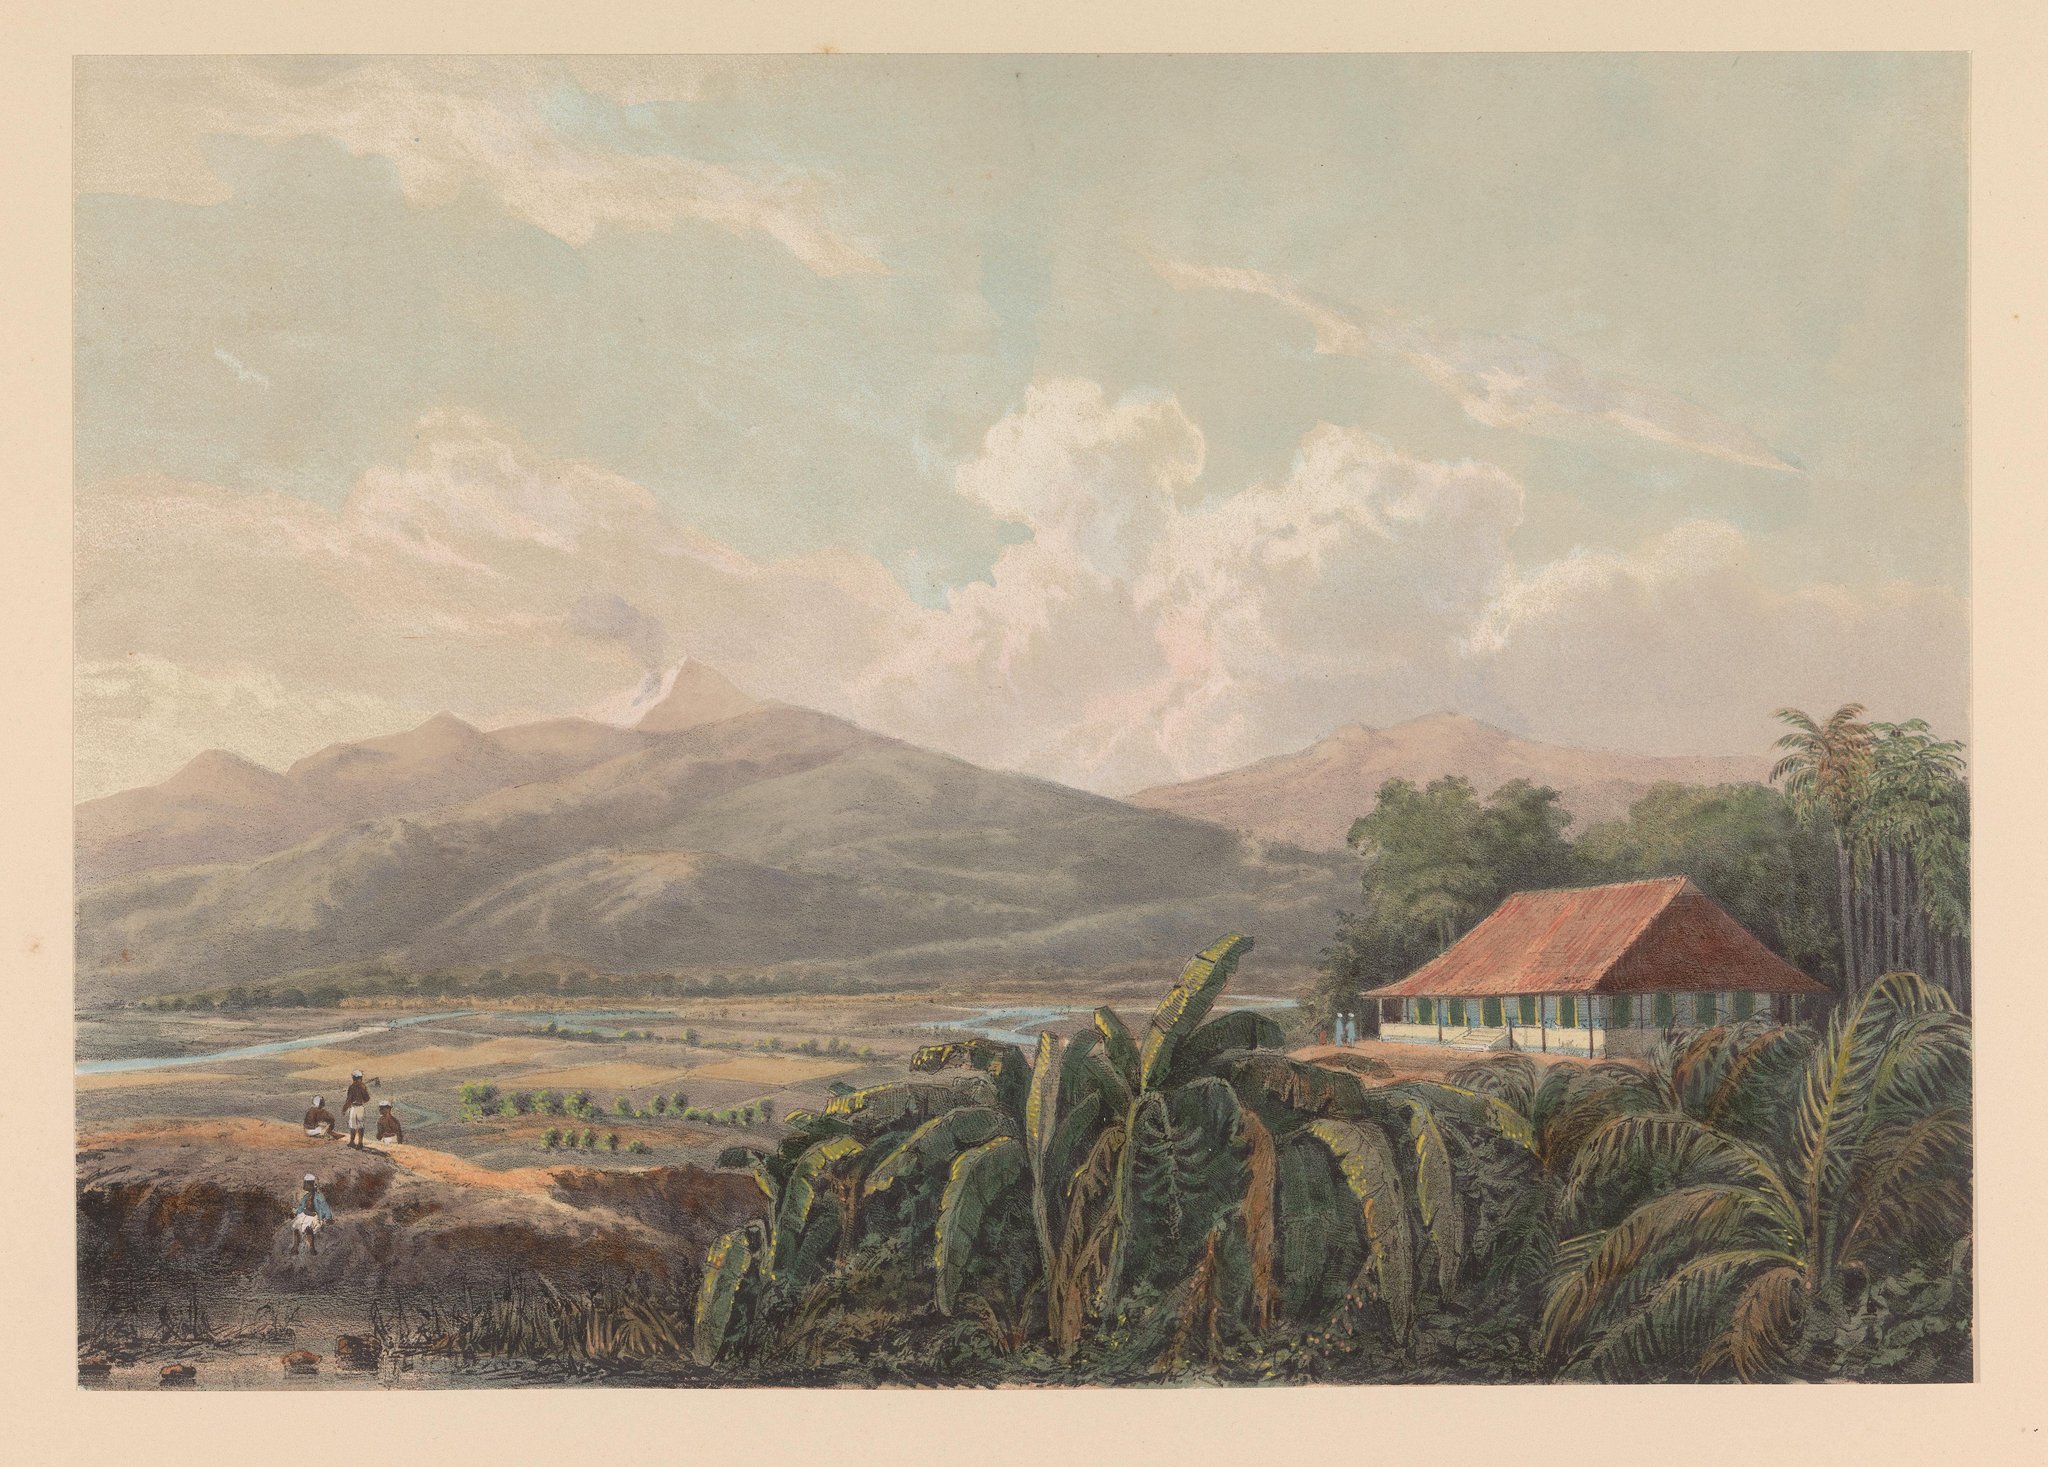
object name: print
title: Het land Tjitrap: Assistent-Residentie Buitenzorg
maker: johan conrad greive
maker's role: draughtsman, painter, print maker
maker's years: 1837-1891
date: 1865-1872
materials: paper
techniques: lithograph, hand coloring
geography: amsterdam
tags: river, landscapes in the non-temperate zone, exotic landscapes, java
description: Volgens de bijbehorende inhoudsopgave betreft dit de eerste prent uit de reeks van 24.